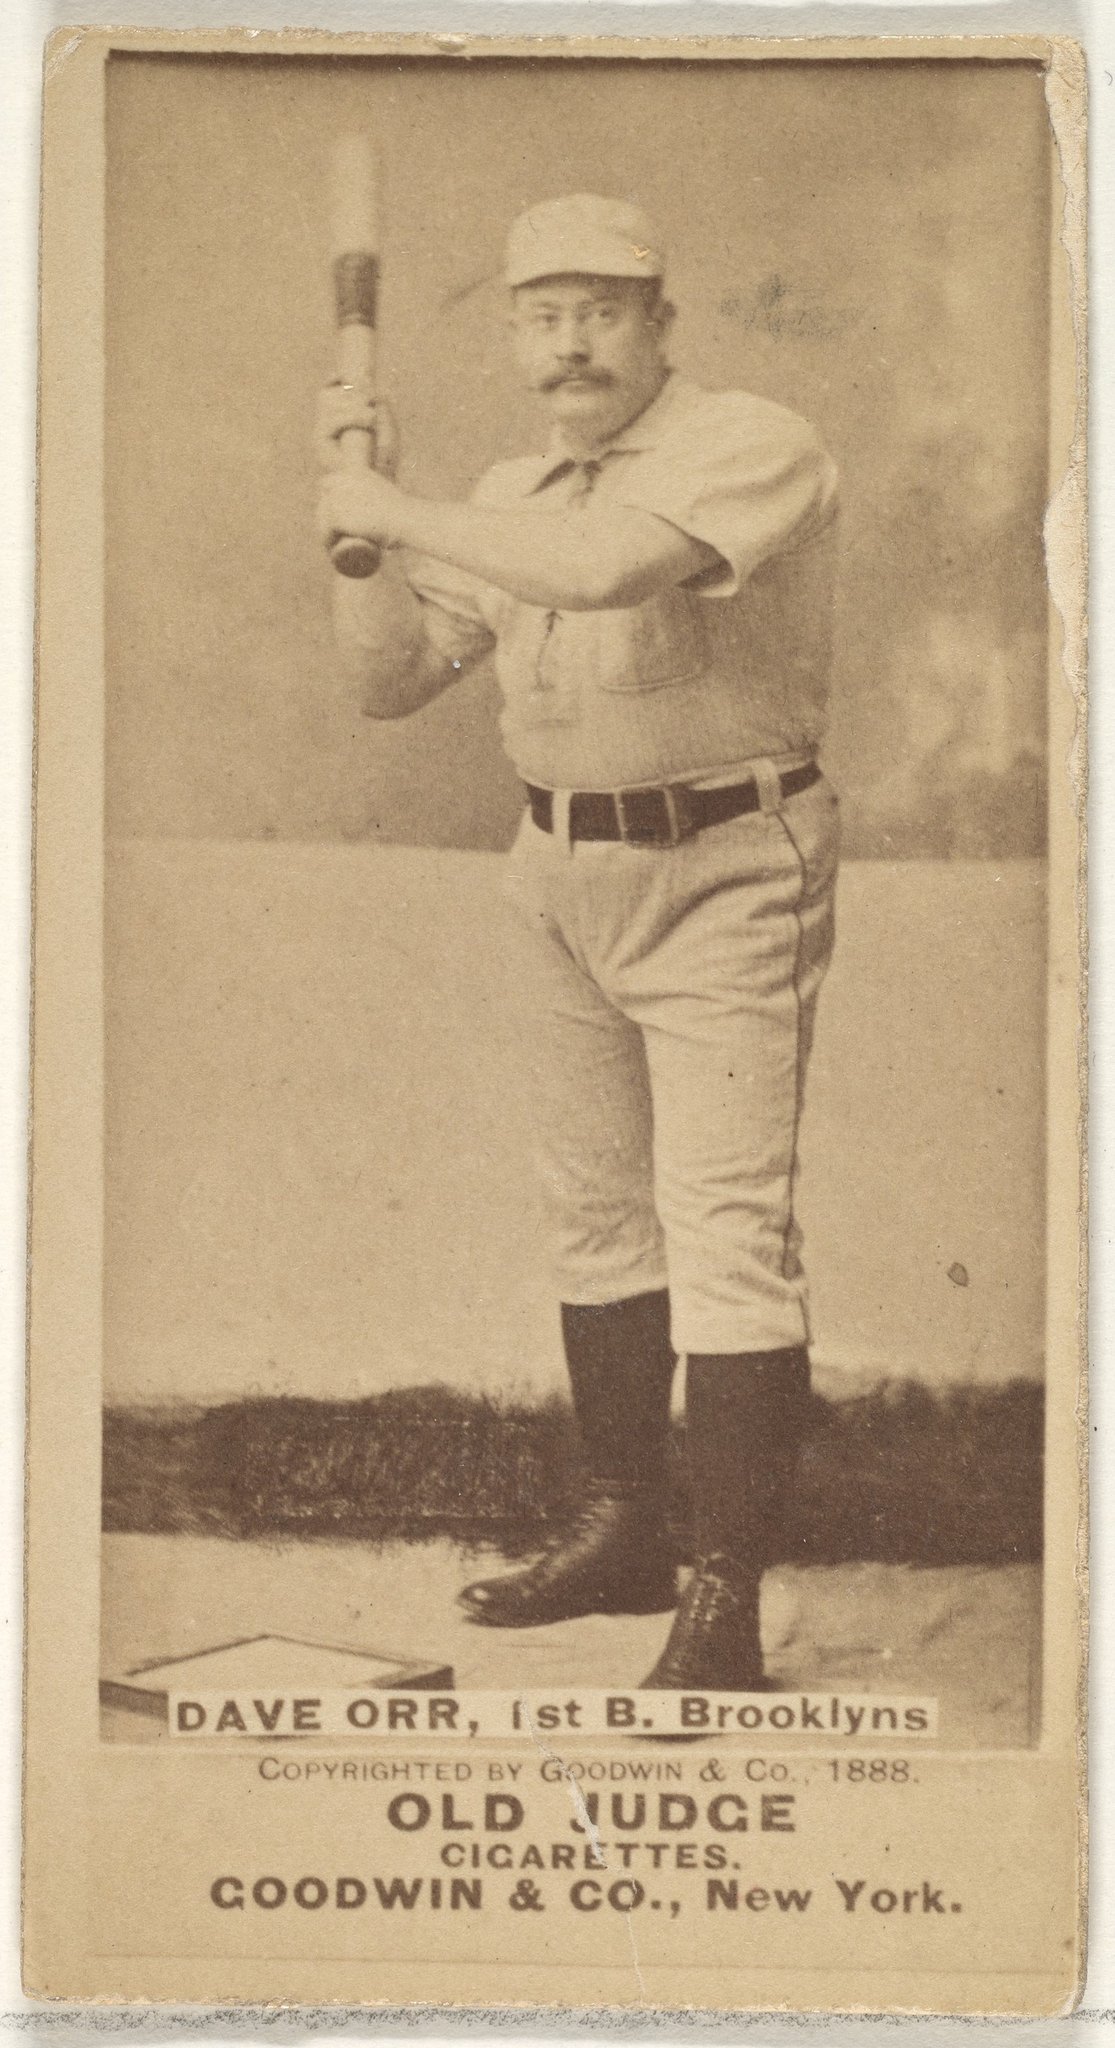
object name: baseball card, photograph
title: Dave Orr, 1st Base, Brooklyn Bridegrooms, from the Old Judge series (N172) for Old Judge Cigarettes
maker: goodwin & company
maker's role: publisher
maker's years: 1850-1950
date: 1888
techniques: albumen silver print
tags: men,portraits,baseball,athletes